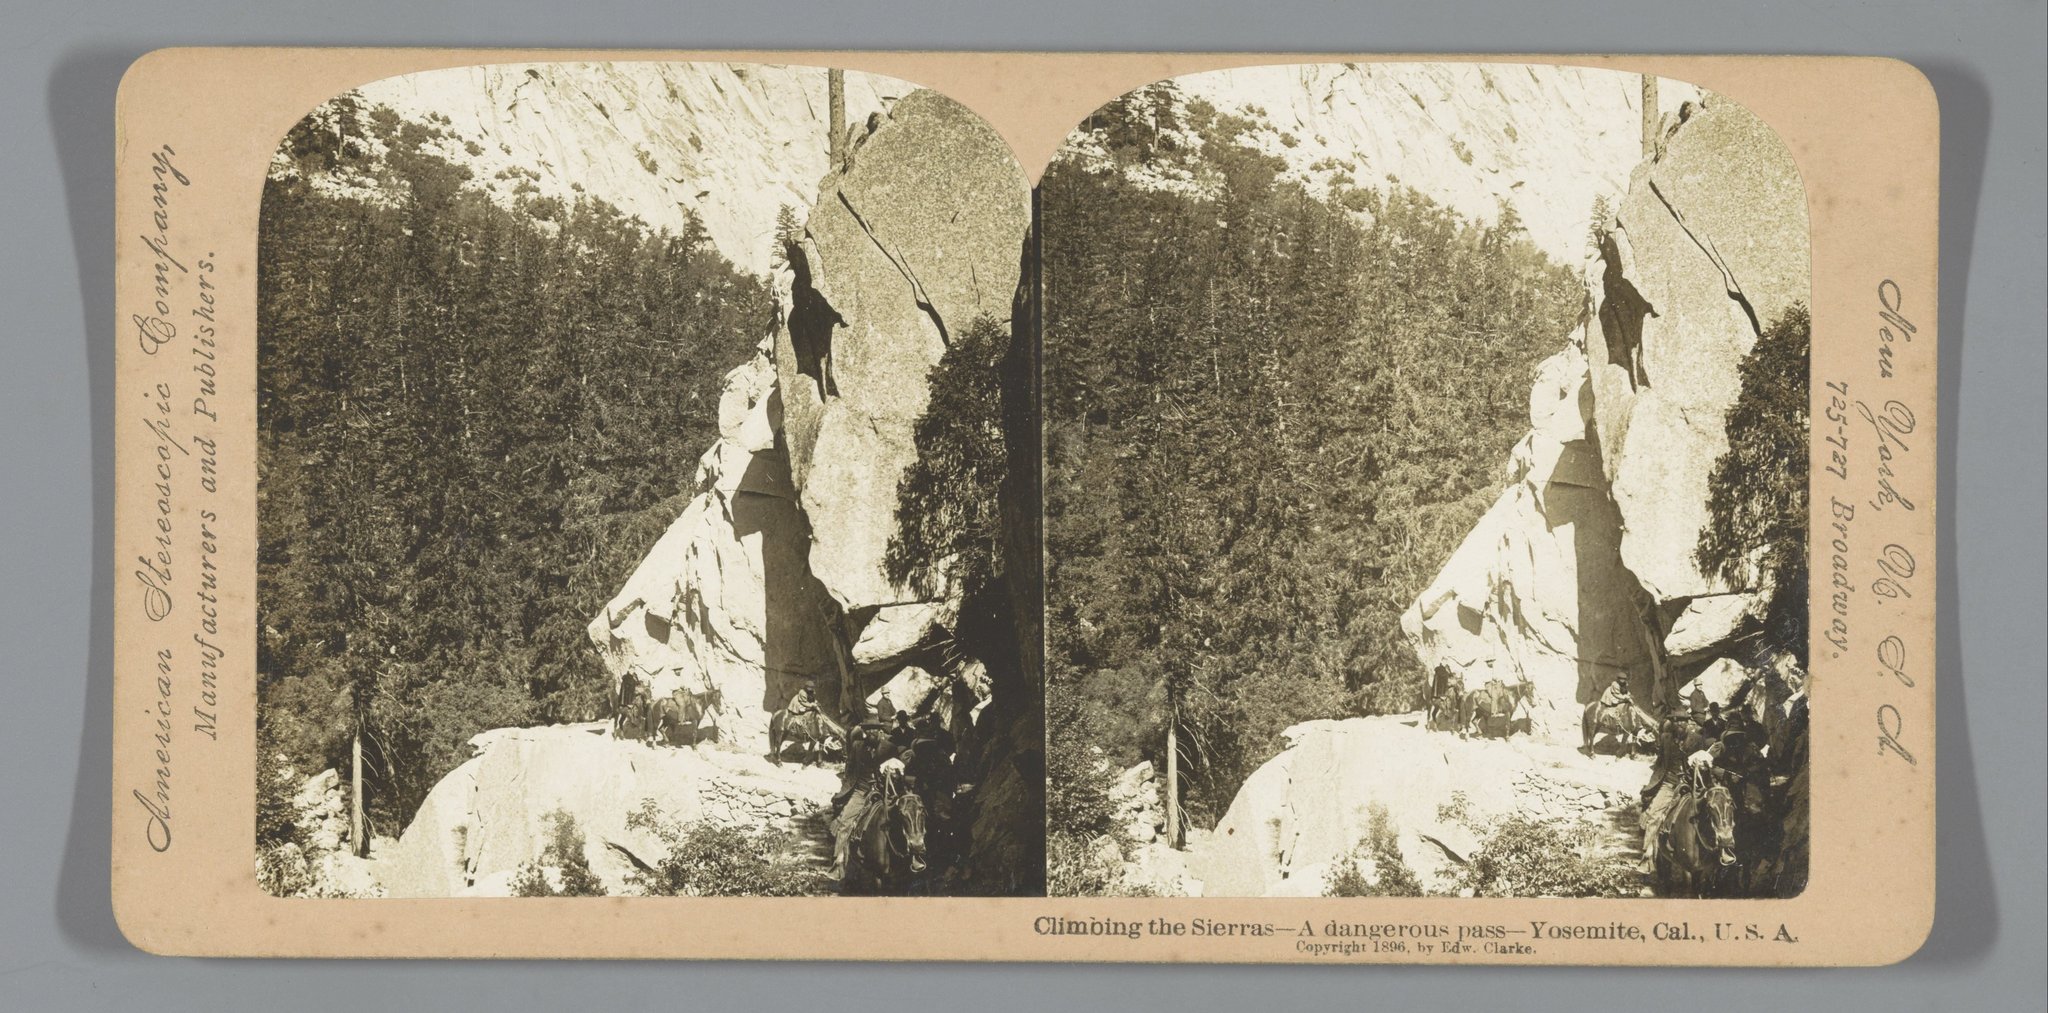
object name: stereograph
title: Ruiters langs een bergwand in Yosemite National Park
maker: edw. clarke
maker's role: fotograaf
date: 1896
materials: paper, cardboard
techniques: gelatin silver print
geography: new york city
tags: ravine, chasm, abyss, canyon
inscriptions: copyright notice: ‘Copyright 1896, by Edw. Clarke.’